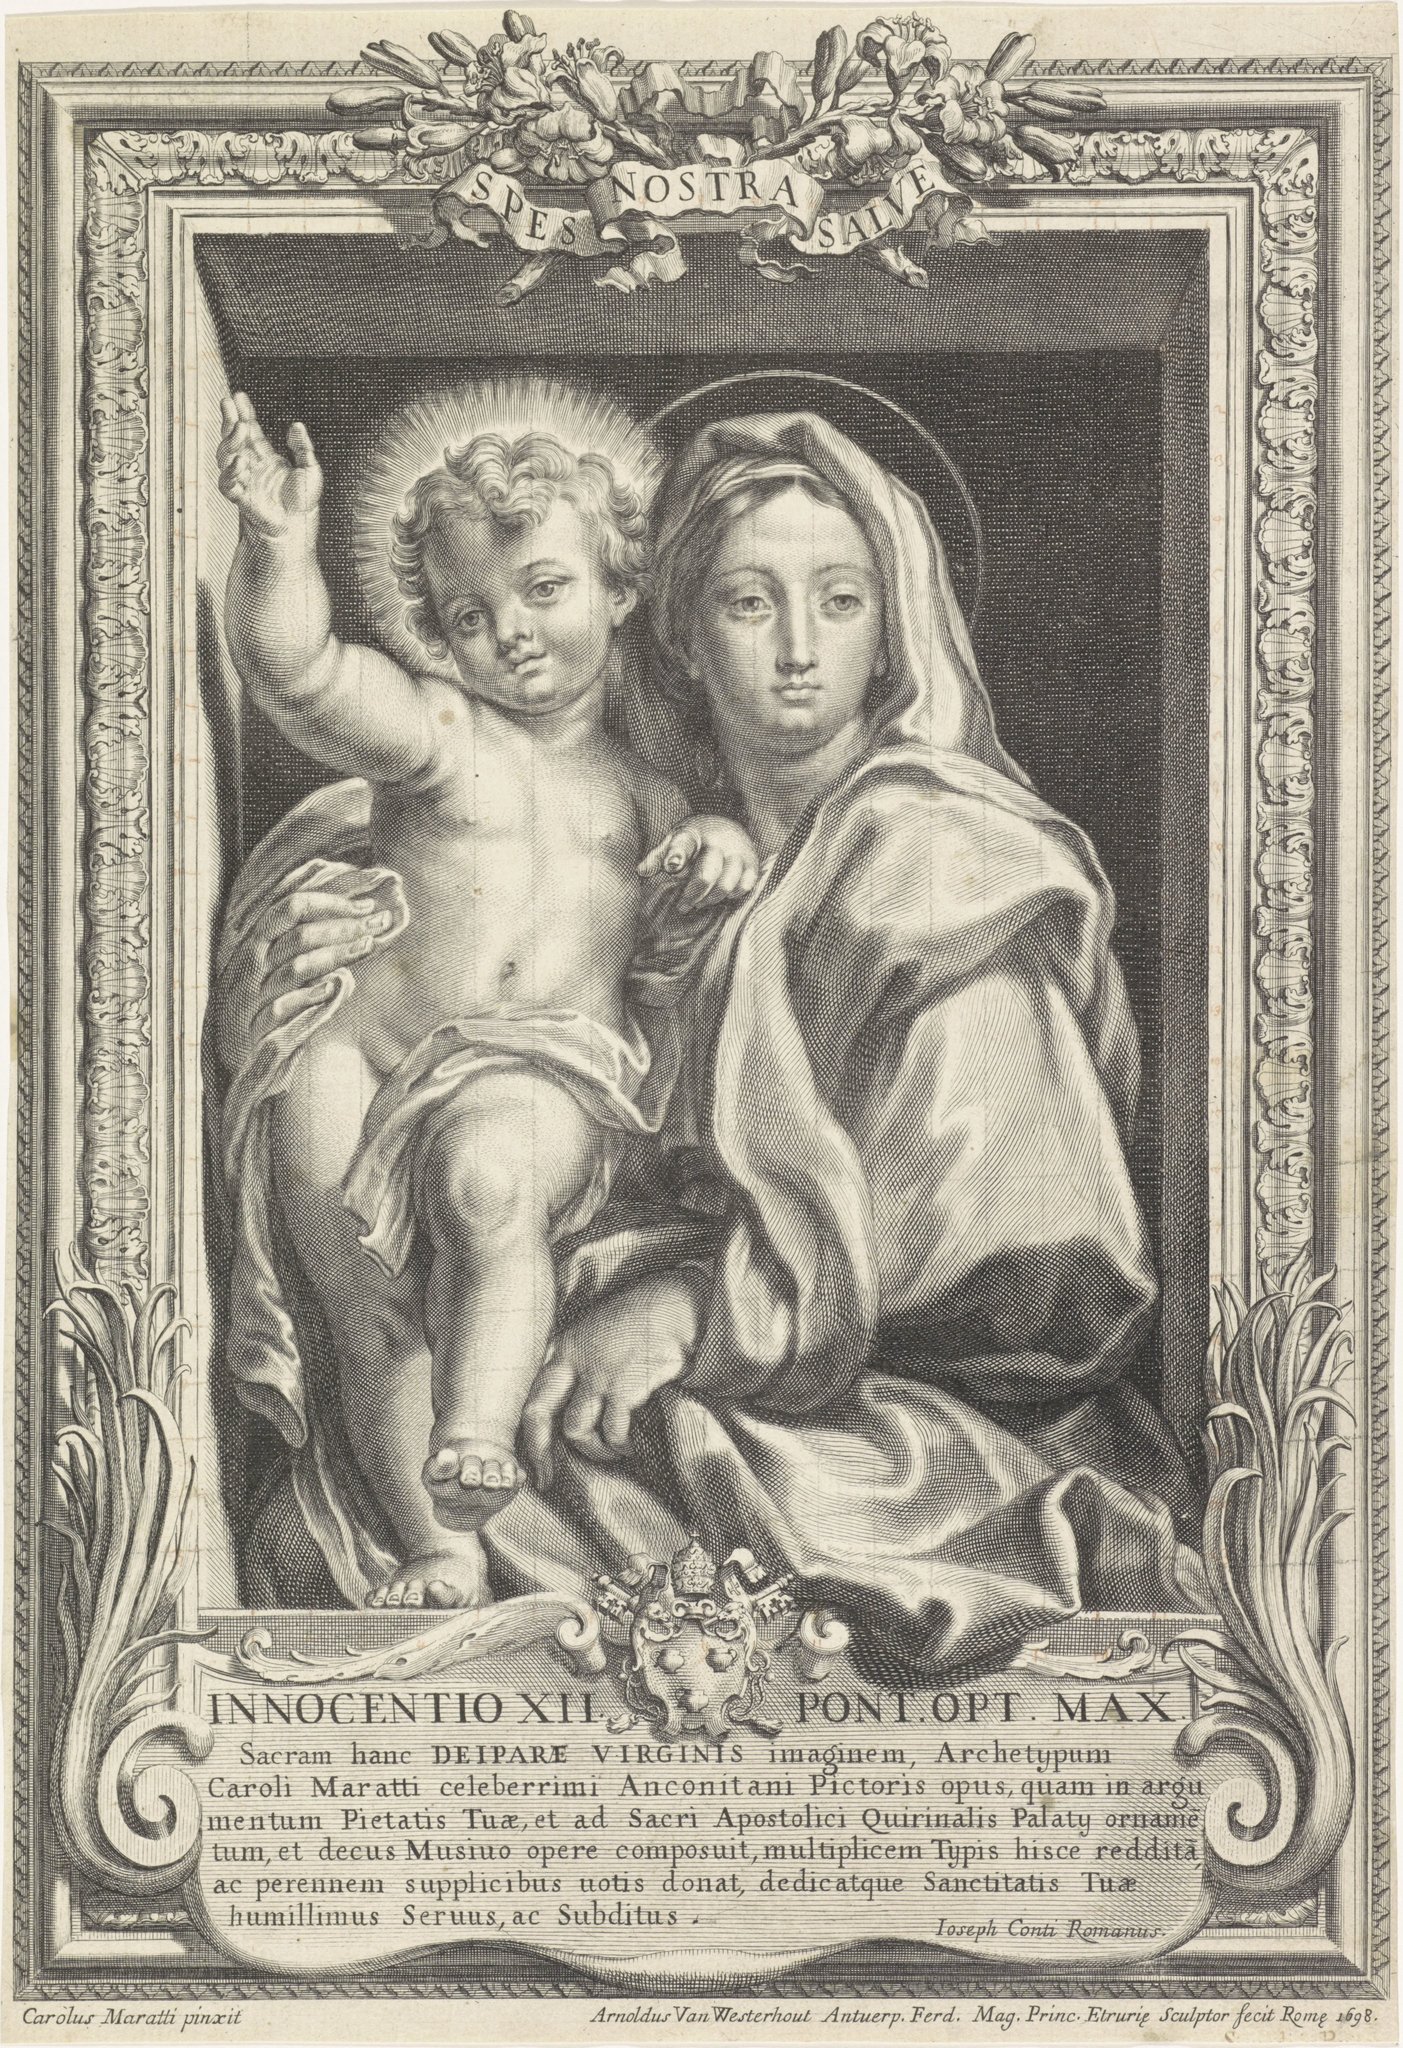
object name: print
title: Maria met het Christuskind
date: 1698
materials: paper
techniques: engraving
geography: rome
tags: naples, rome, clergyman, innocentius xii, mary sitting or enthroned, the christ-child standing on her knee (christ-child to mary's left) - ff - the christ-child to mary's right, armorial bearing, heraldry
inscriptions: collector's mark: Lugt 2228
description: Maria slaat een arm om het Christuskind. Het Kind maakt een zegenend gebaar. In de cartouche onder de voorstelling het wapenschild van paus Innocentius XII en een zesregelig onderschrift in het Latijn.